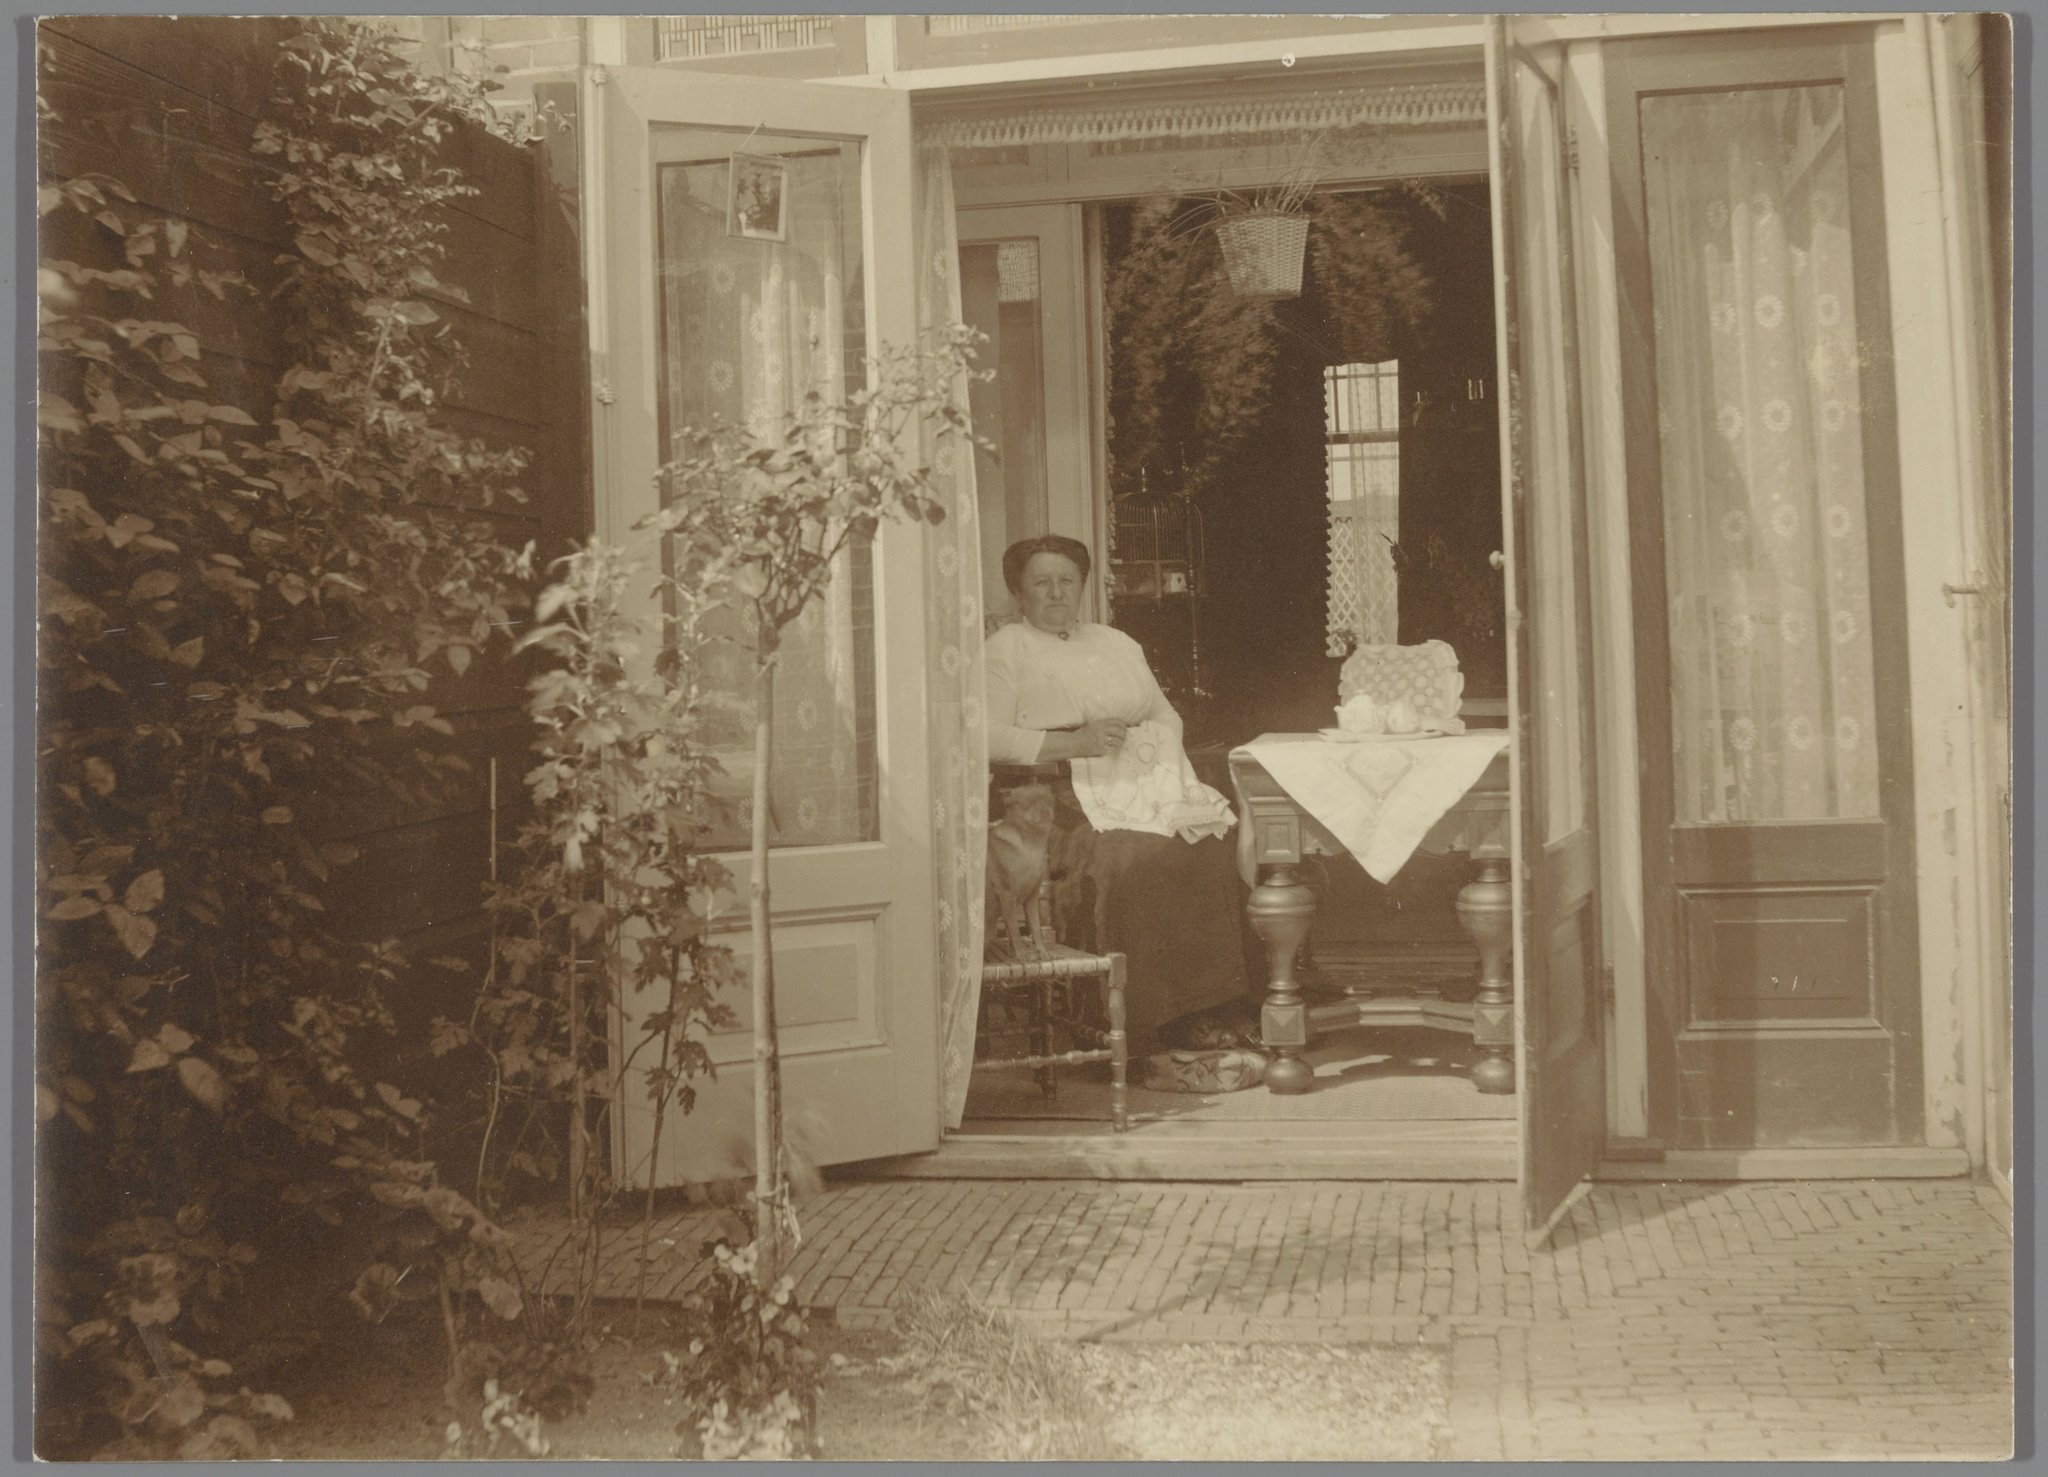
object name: photograph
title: Vrouw met handwerk in een huiskamer, gezien vanuit de tuin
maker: Anonymous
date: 1890-1920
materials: paper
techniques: gelatin silver print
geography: netherlands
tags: adult woman